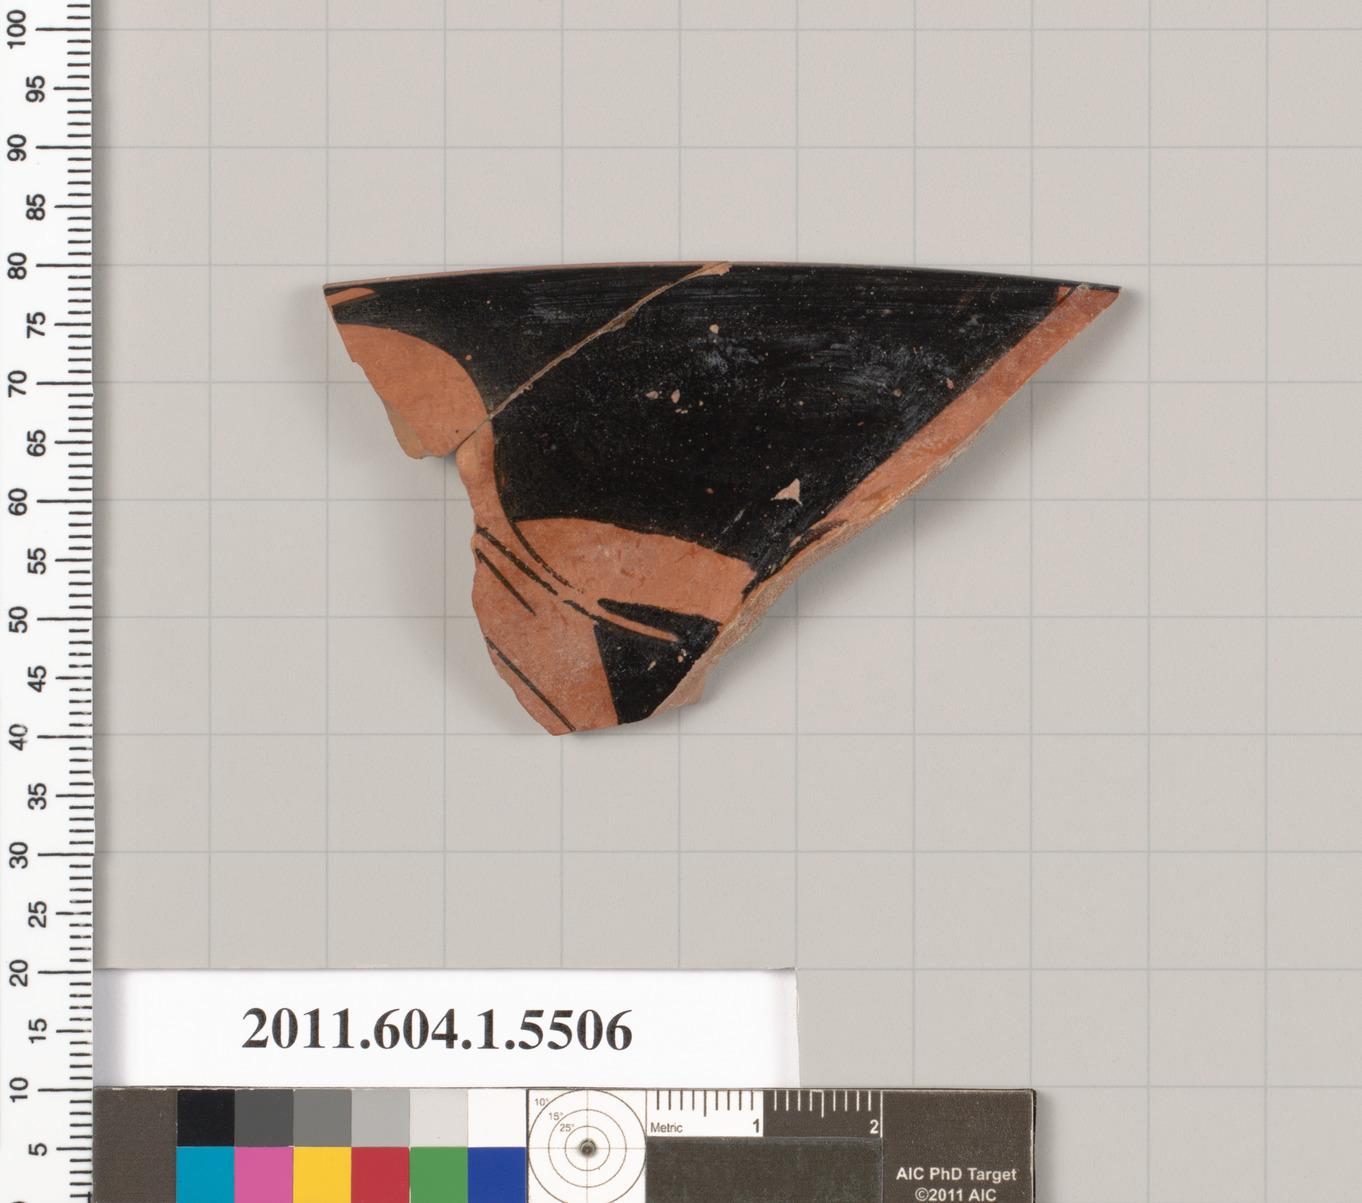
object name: kylix fragment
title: Terracotta rim fragment of a kylix (drinking cup)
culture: greek, attic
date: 520-510 BCE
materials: terracotta